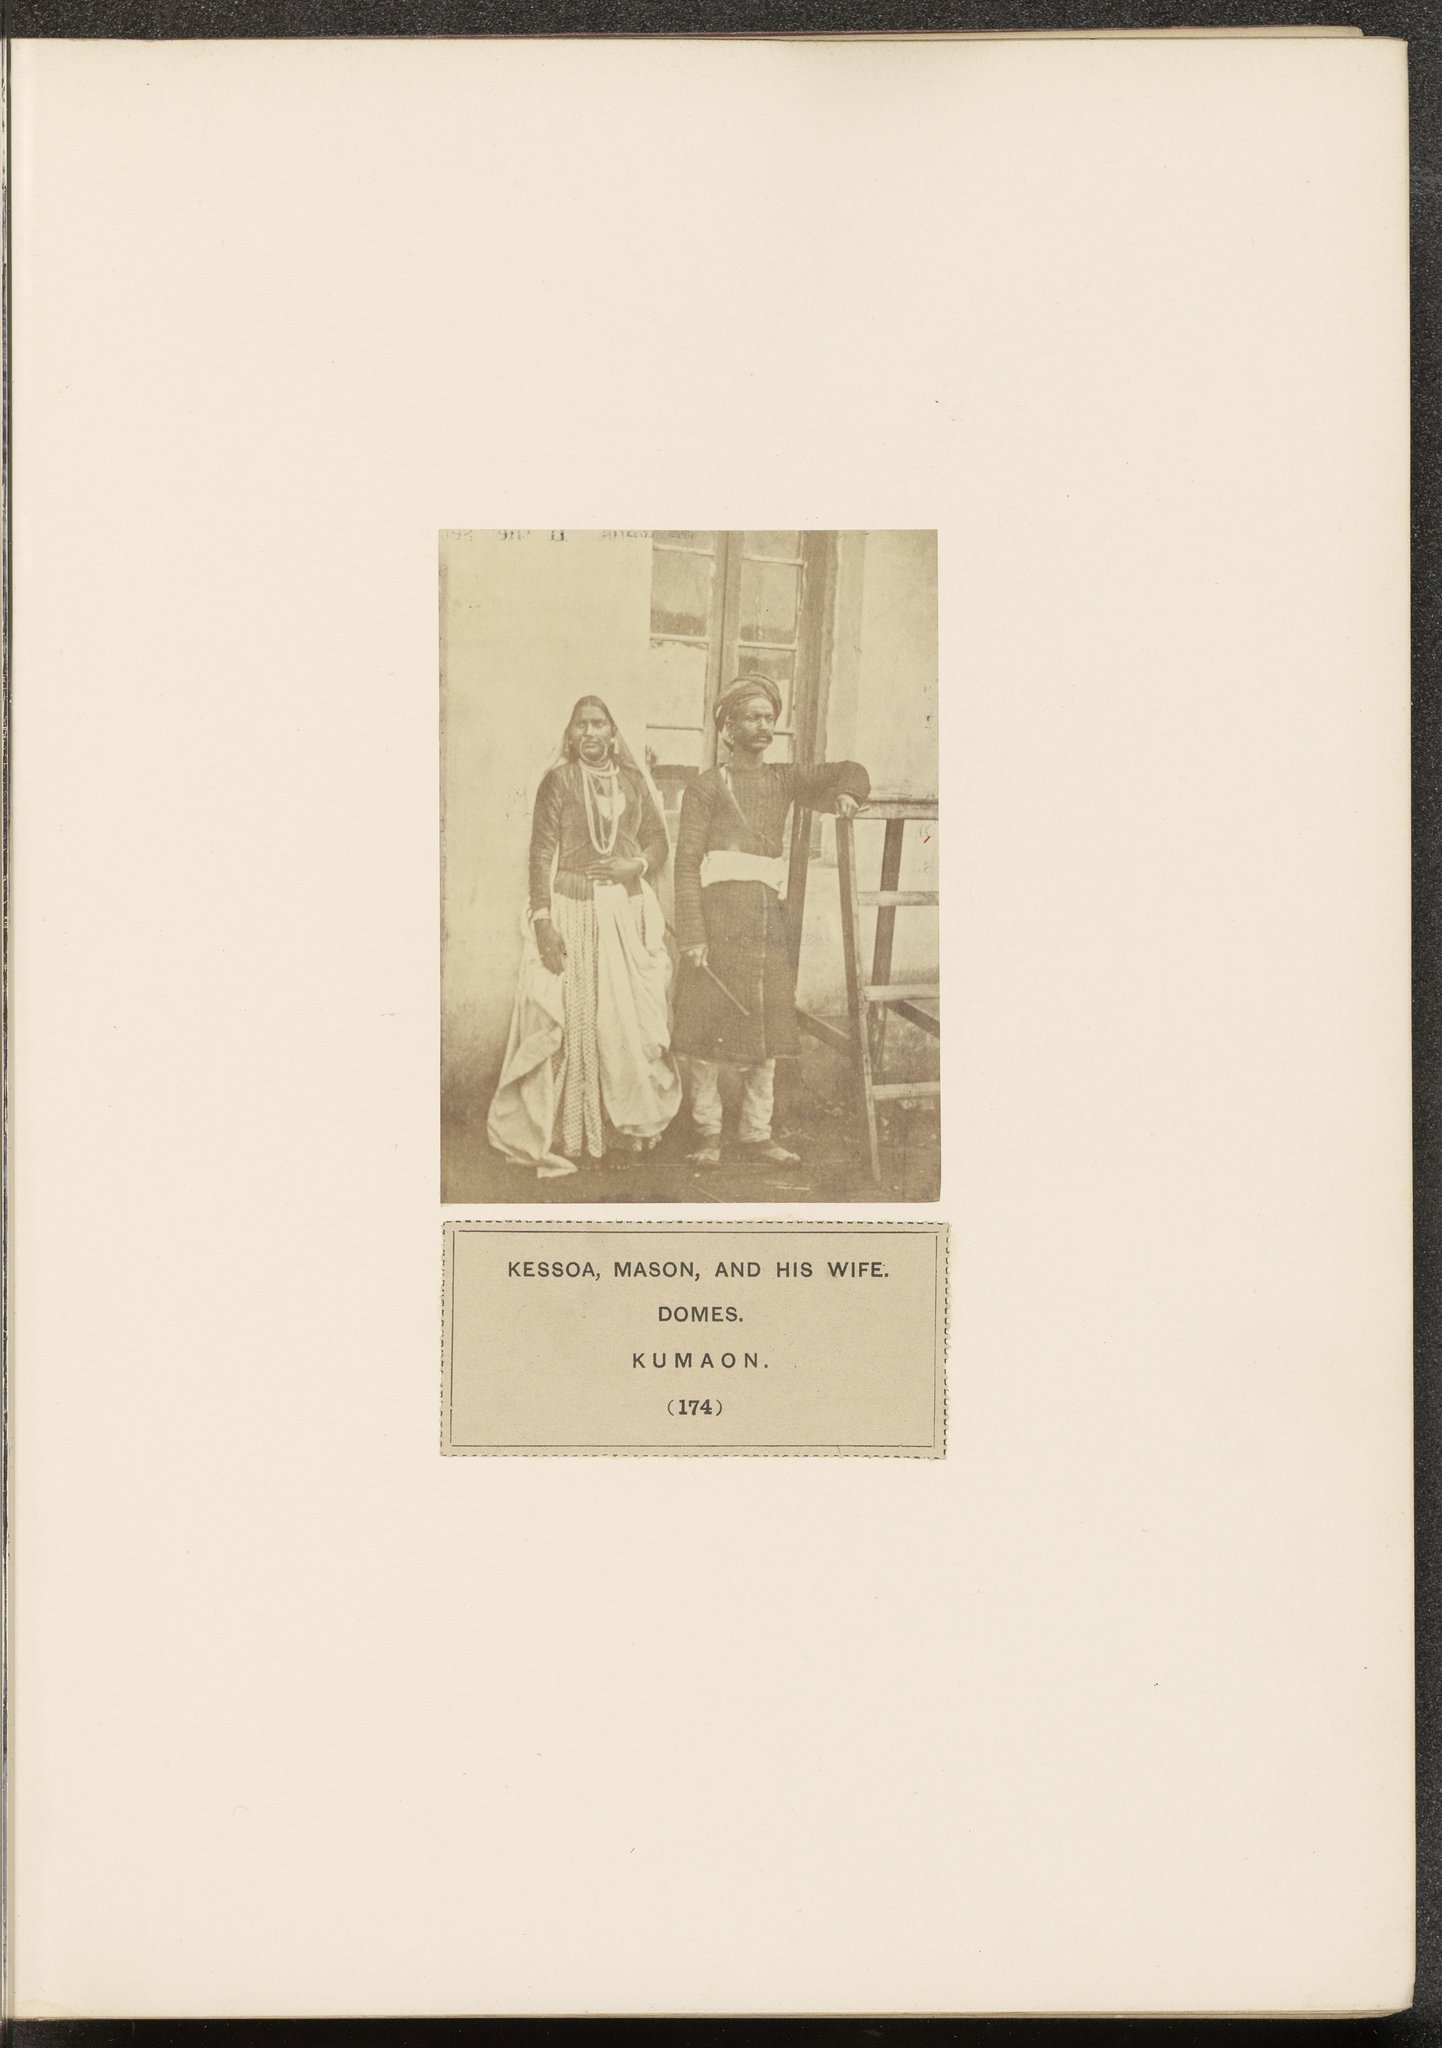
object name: page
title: Portrait of a couple in front of a house in Kumaon, Uttarakhand, India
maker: Anonymous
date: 1859-1869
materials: photographic support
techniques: albumen print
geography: kumaon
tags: human races; peoples; nationalities, couple of lovers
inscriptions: inscription: ‘KESSOA, MASON, AND HIS WIFE./ DOMES./ KUMAON.’, number: ‘(174)’